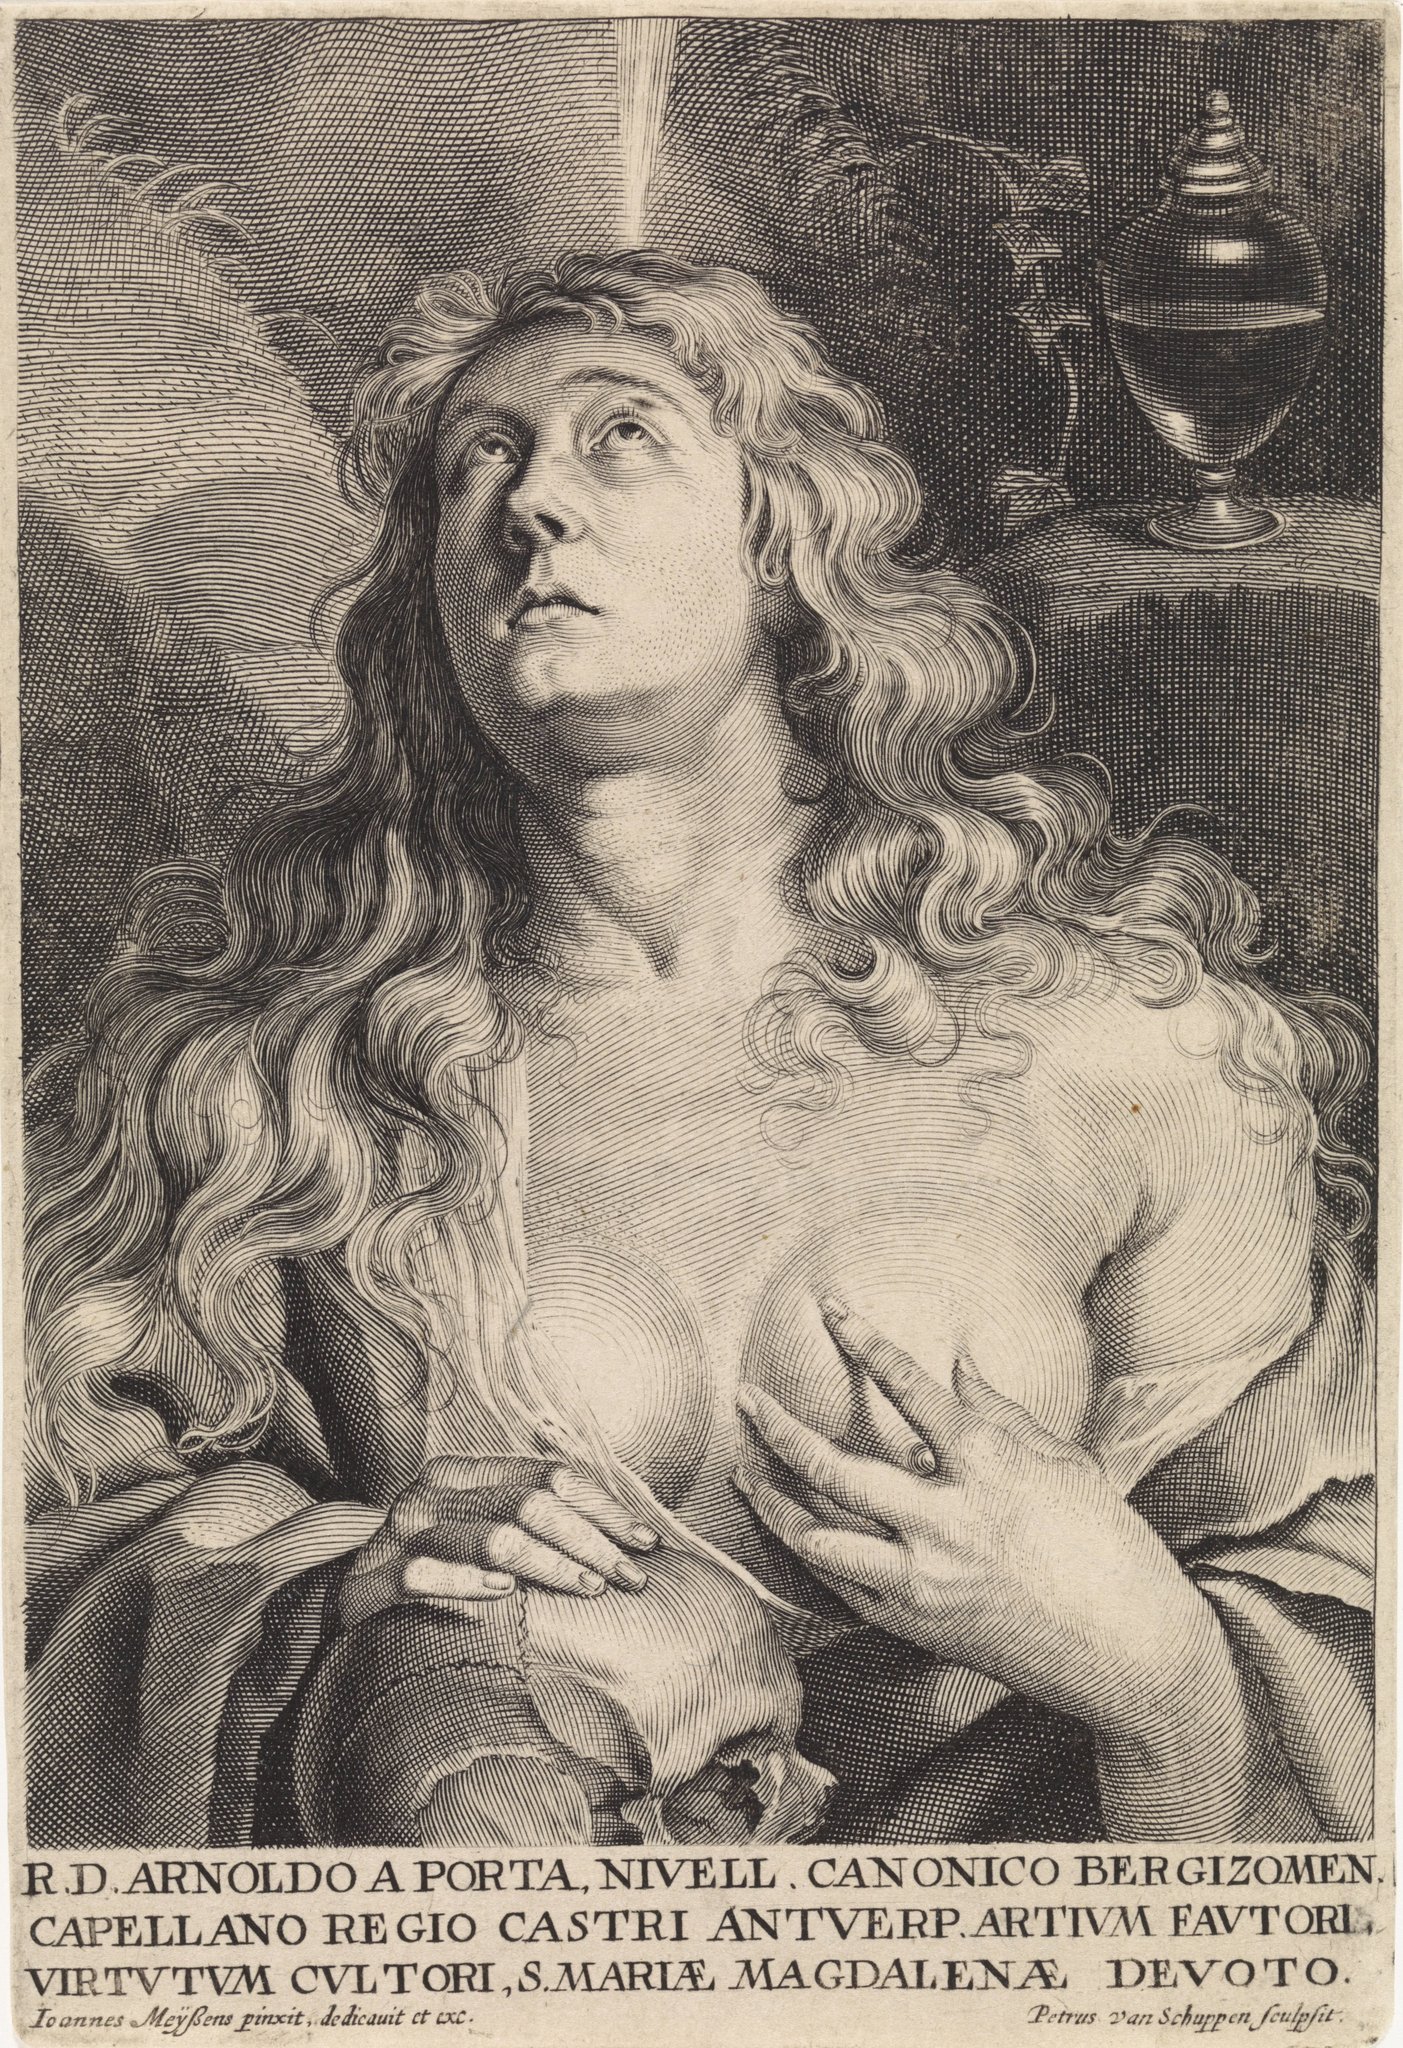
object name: print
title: Maria Magdalena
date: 1638-1655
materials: paper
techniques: engraving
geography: antwerp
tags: the penitent harlot mary magdalene; possible attributes: book (or scroll), crown, crown of thorns, crucifix, jar of ointment, mirror, musical instrument, palm-branch, rosary, scourge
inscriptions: collector's mark: ‘H.M. 1884’, collector's mark: Lugt 2228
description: Maria Magdalena, met ontblote borsten, heft haar ogen ten hemel. Haar hand rust op een schedel. Achter haar staat haar vaas met olie op een verhoging. In de marge een opdracht aan de Antwerpse pastoor Arnold de la Porte.